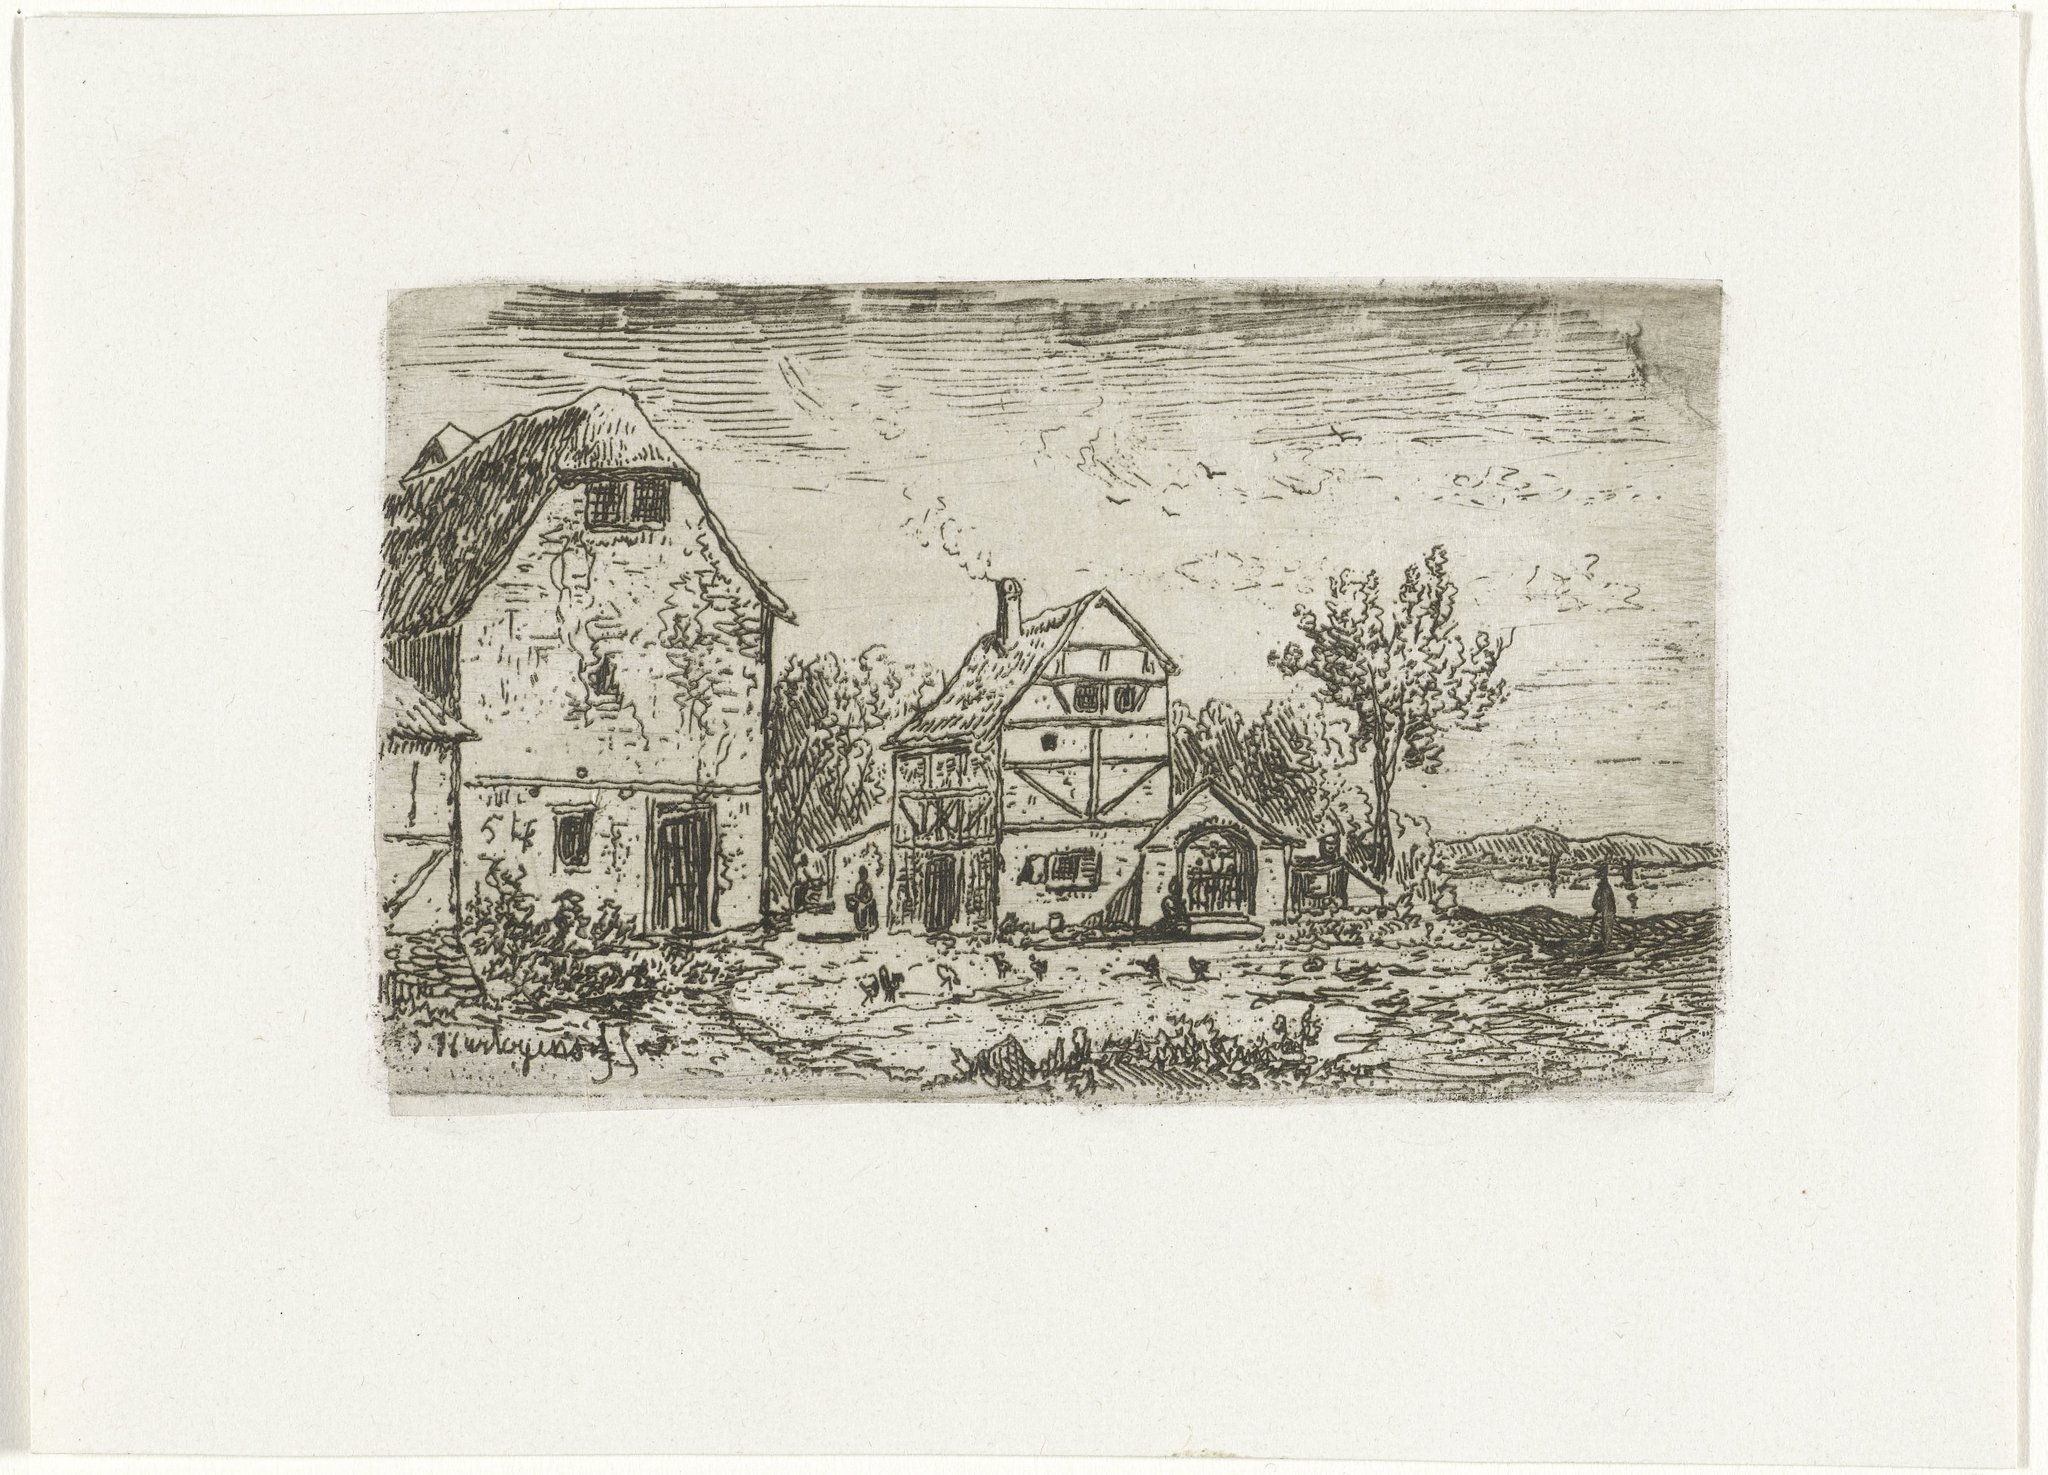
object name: print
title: Gebouwen aan de Aar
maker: joseph hartogensis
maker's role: painter, print maker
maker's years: 1822-1865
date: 1837-1865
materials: paper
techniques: etching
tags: rural housing, e.g. country-house, villa, cottage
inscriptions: collector's mark: Lugt 2228